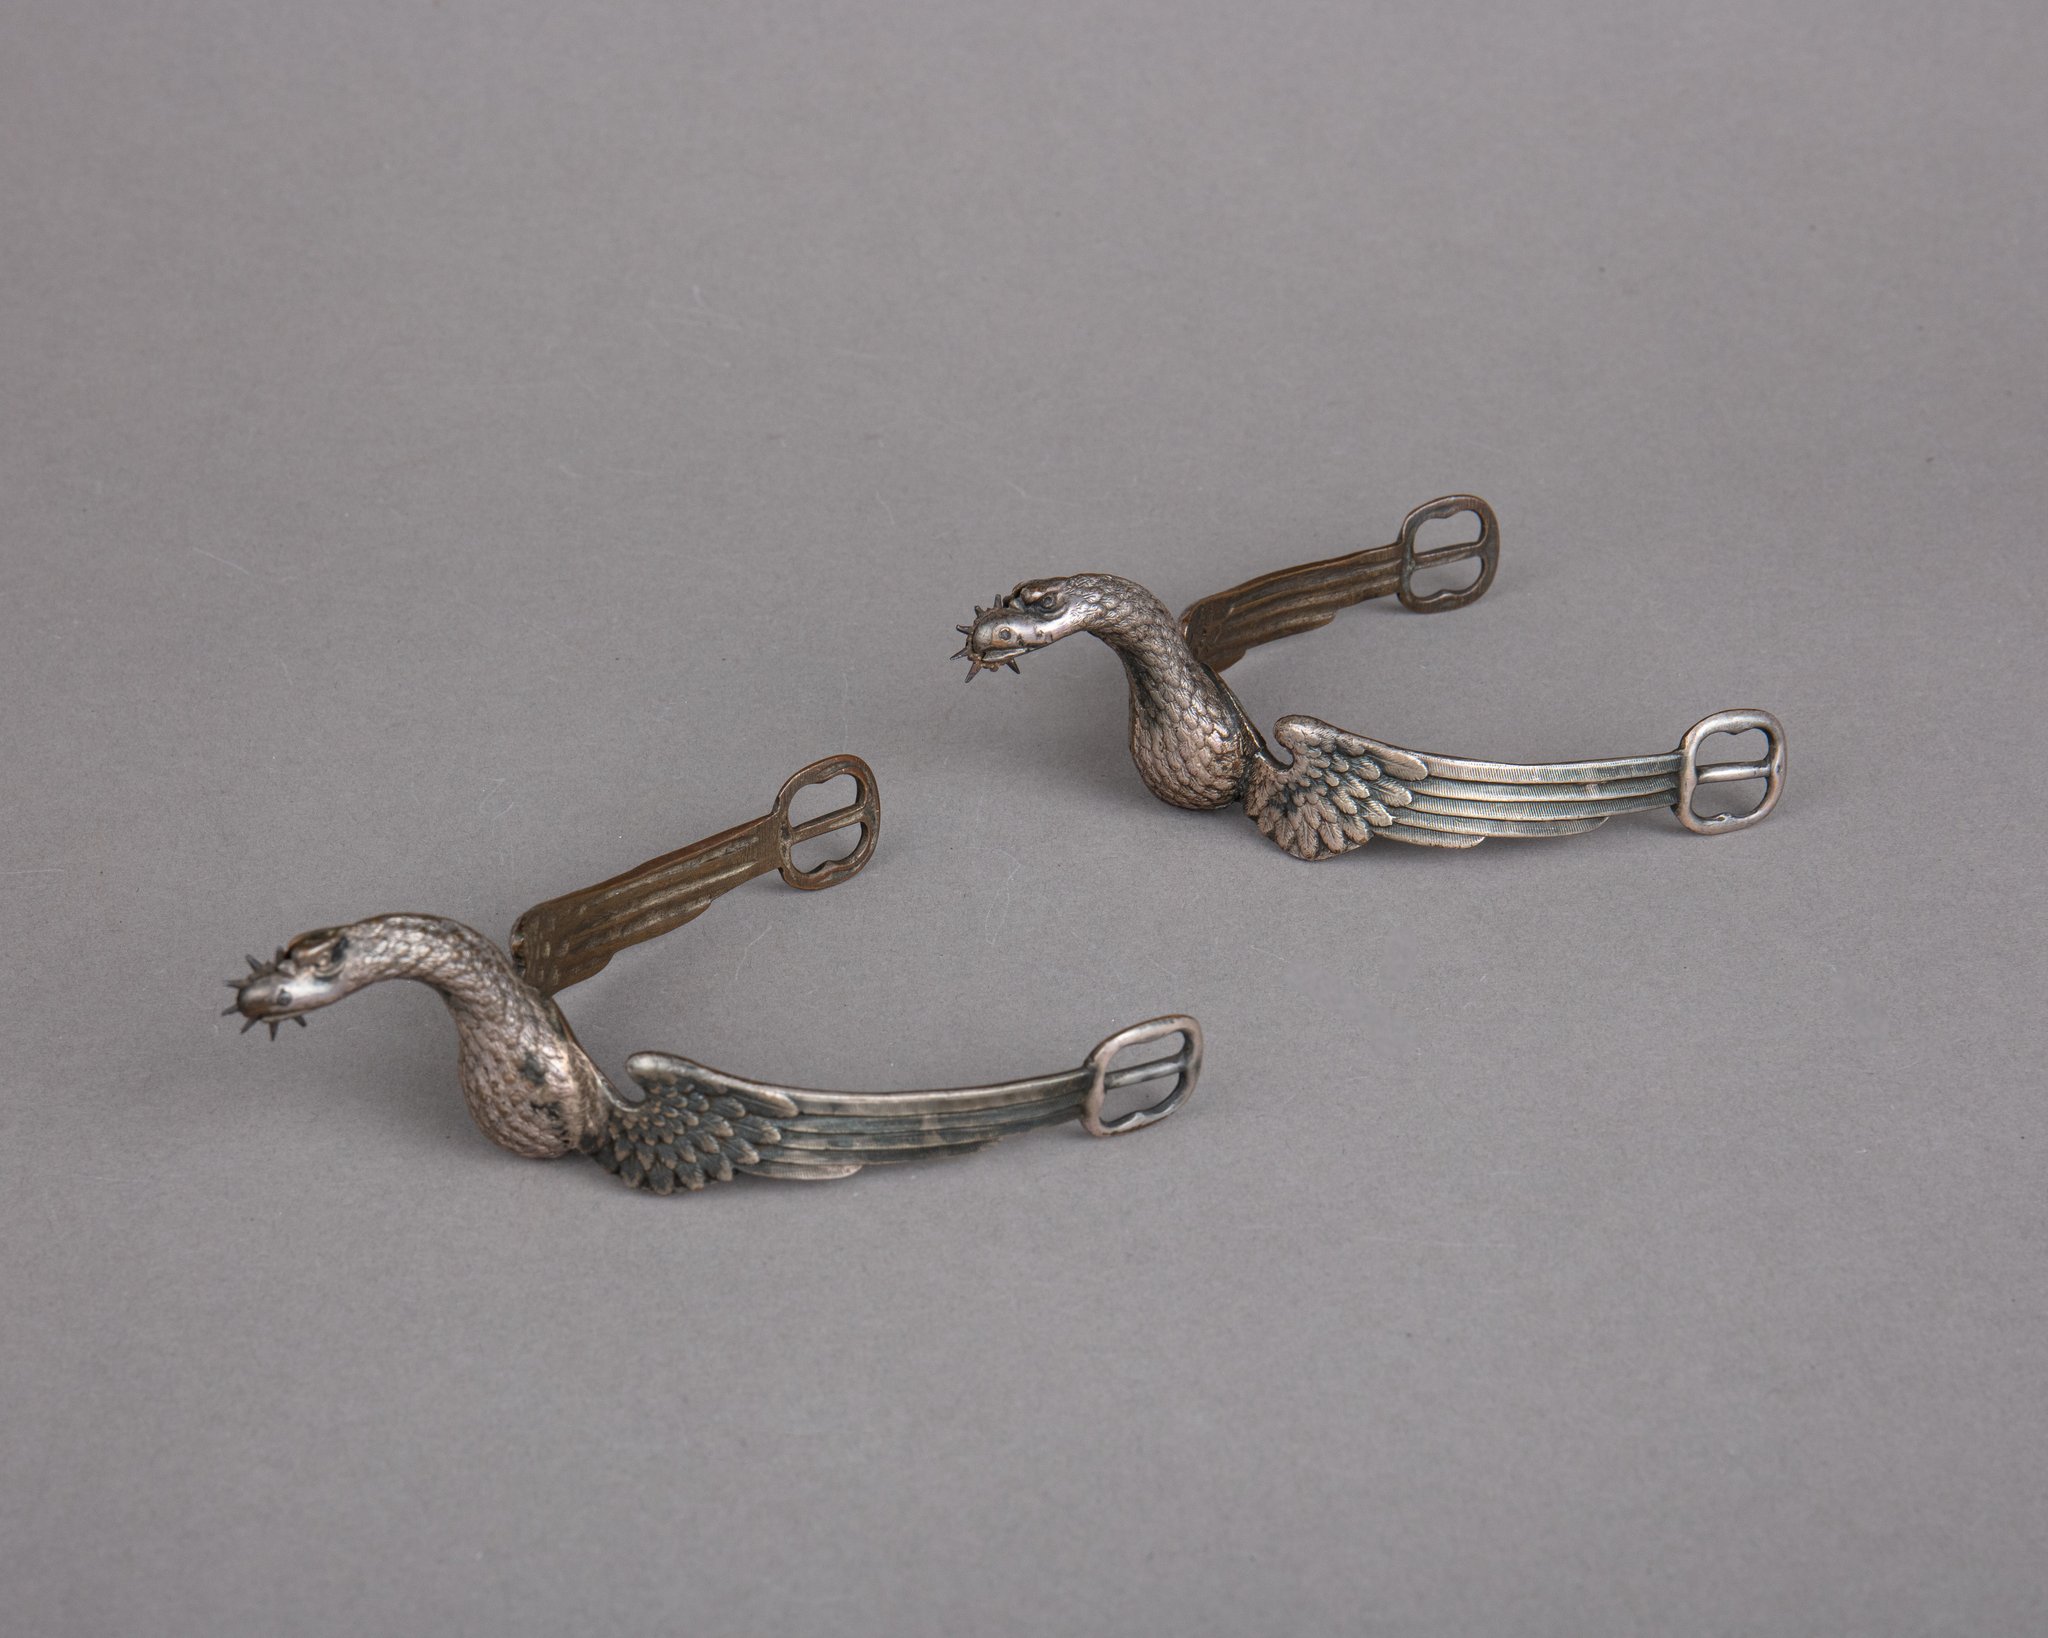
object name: spur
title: Pair of Rowel Spurs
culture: american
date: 1860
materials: copper alloy, iron, silver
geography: united states